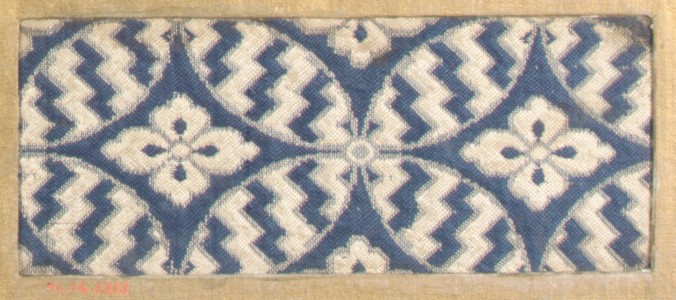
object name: piece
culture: japanese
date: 1701-1900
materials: silk